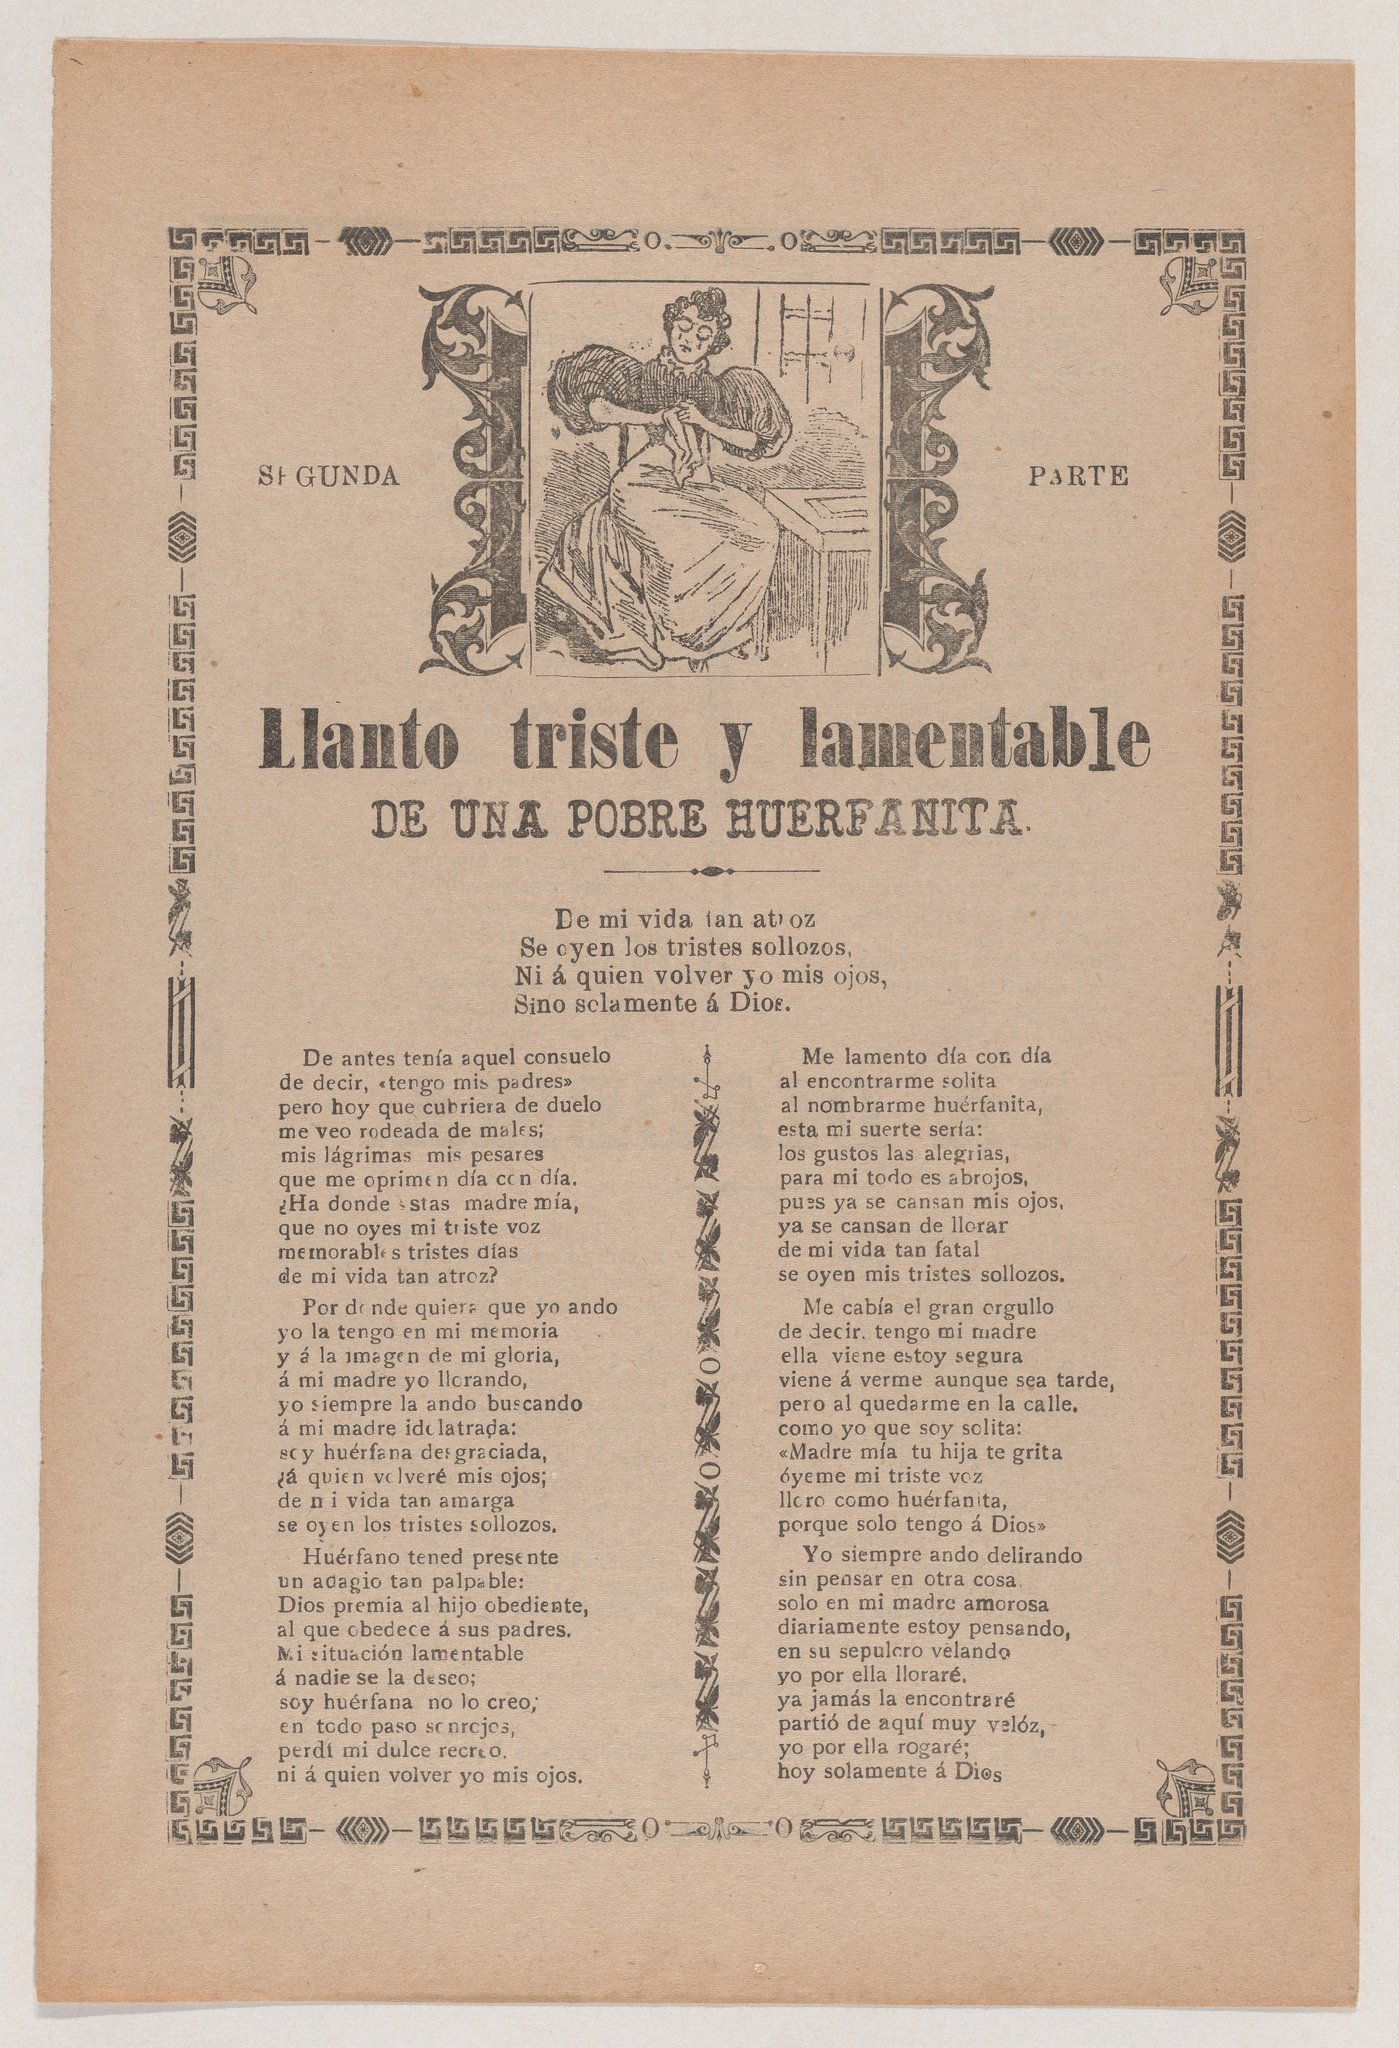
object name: print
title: Broadsheet relating to the sad cry of a poor orphan girl, her lament in verse in the bottom section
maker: josé guadalupe posada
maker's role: artist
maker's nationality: mexican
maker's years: 1852-1913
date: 1895-1910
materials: paper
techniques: letterpress, lithography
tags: girls